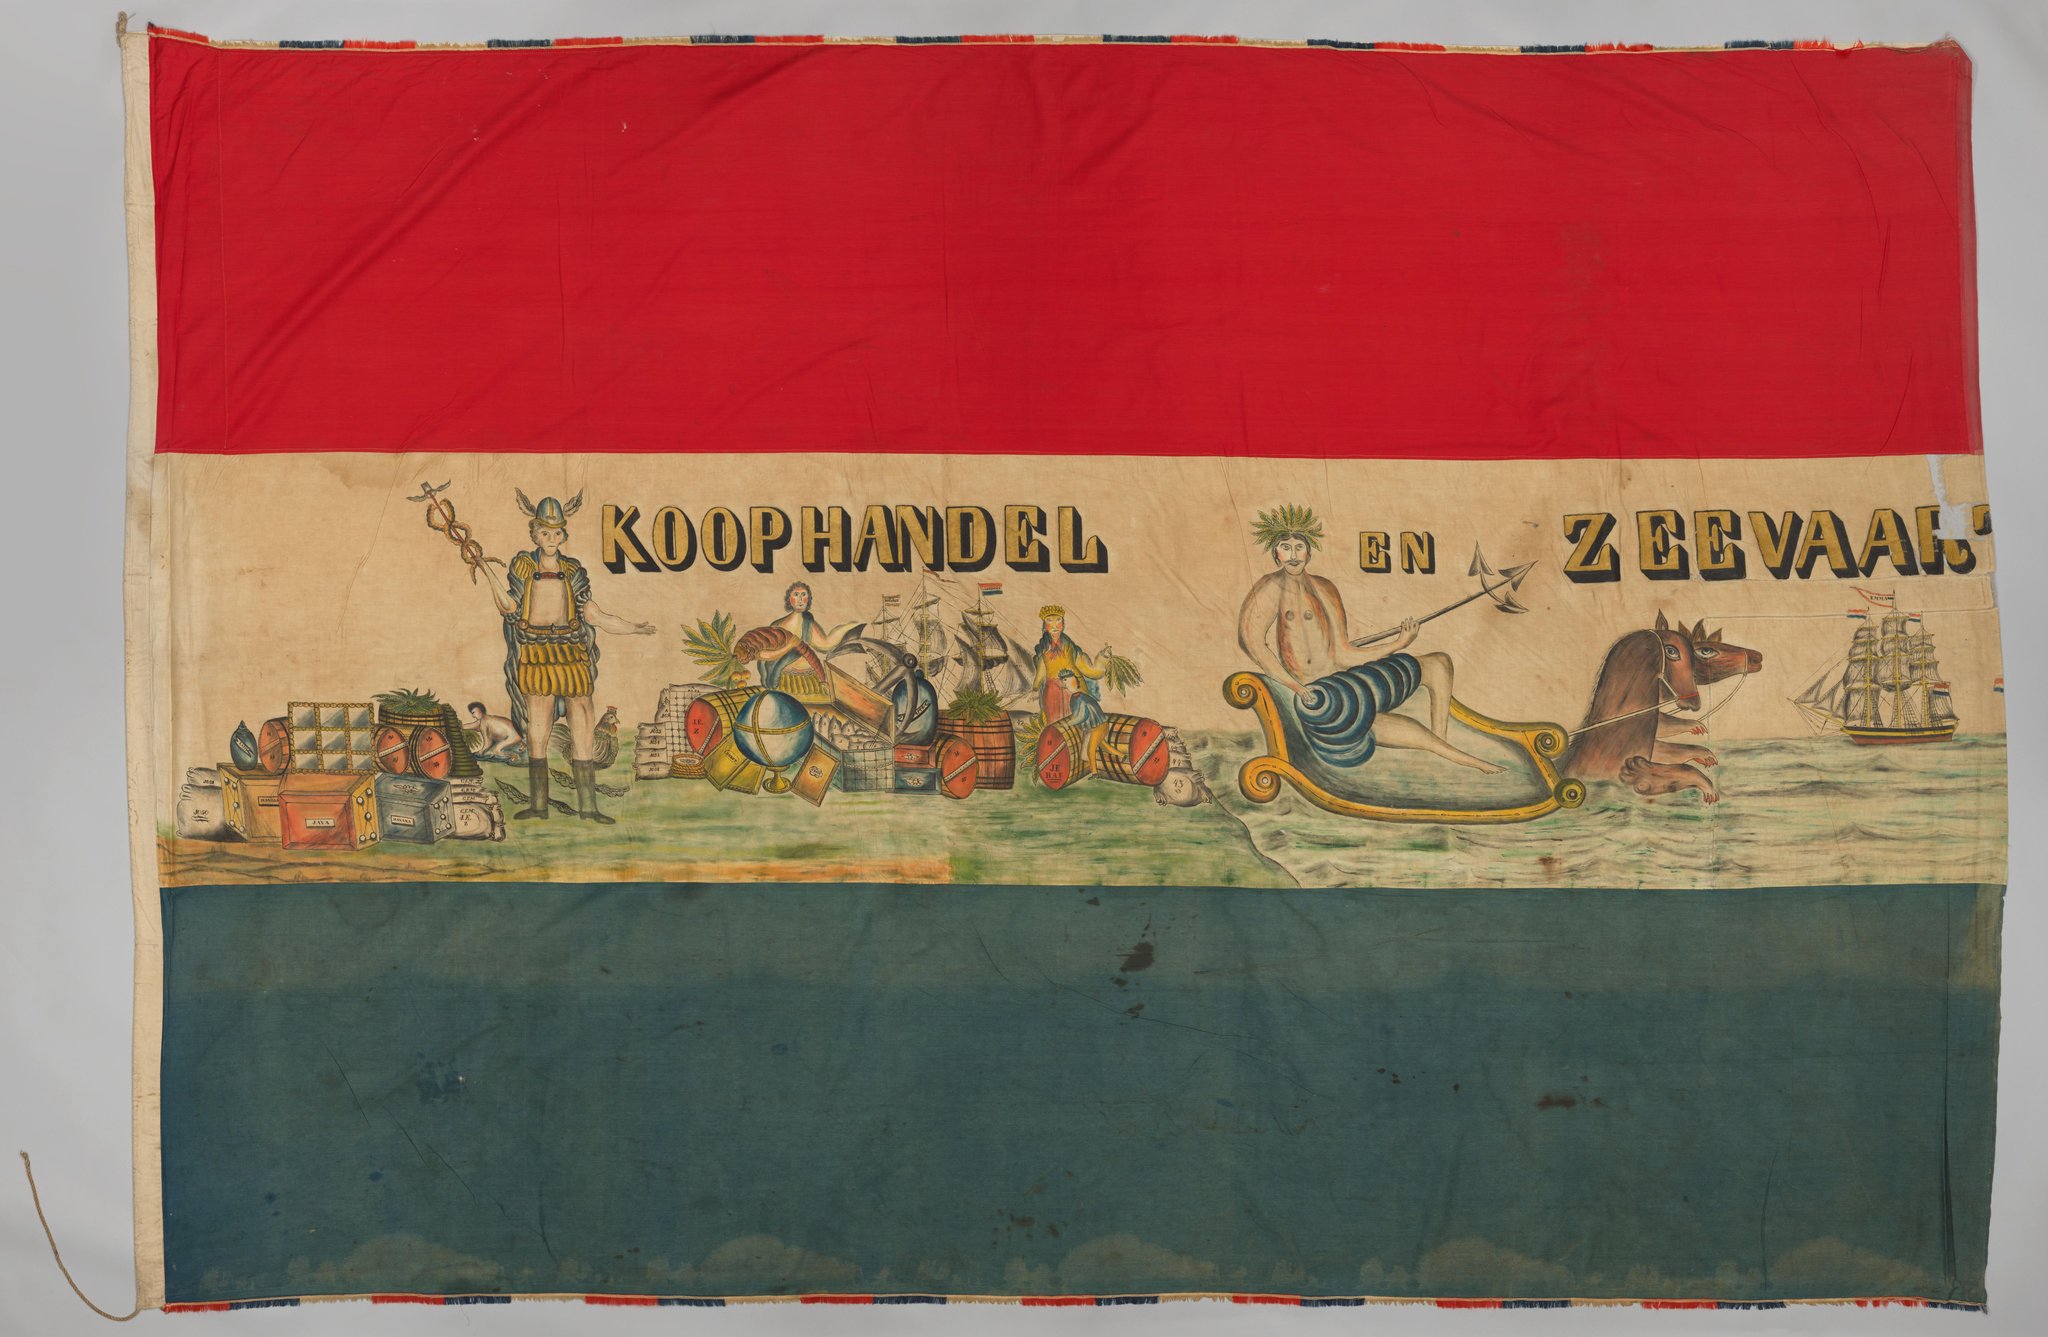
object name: flag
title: Nederlandse vlag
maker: Anonymous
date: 1897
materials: cotton, paint, wool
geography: netherlands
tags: the hague, wilhelmina of the netherlands, emma (queen consort of the netherlands), specific aspects, allegorical aspects of neptune; neptune as patron, specific aspects, allegorical aspects of mercury; mercury as patron, merchant shipping, shipping trade